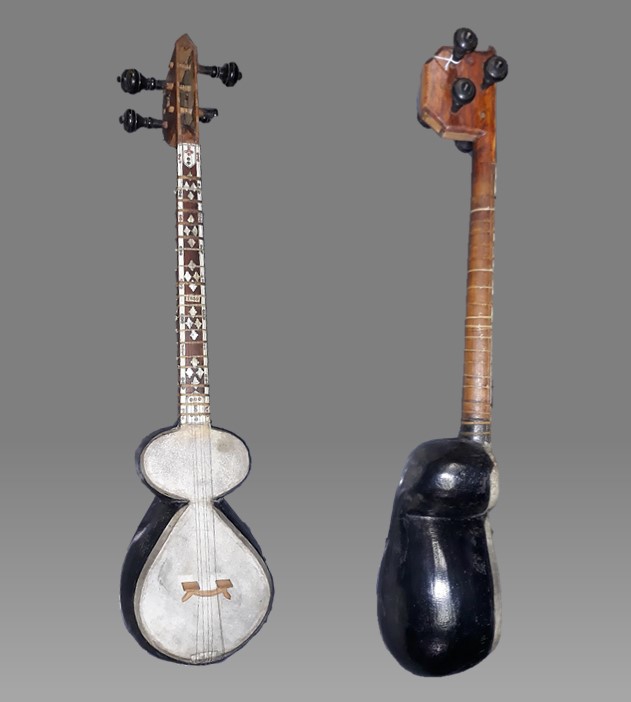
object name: tar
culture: azerbaijani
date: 1867-1900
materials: metal, mother of pearl, skin, wood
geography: georgia